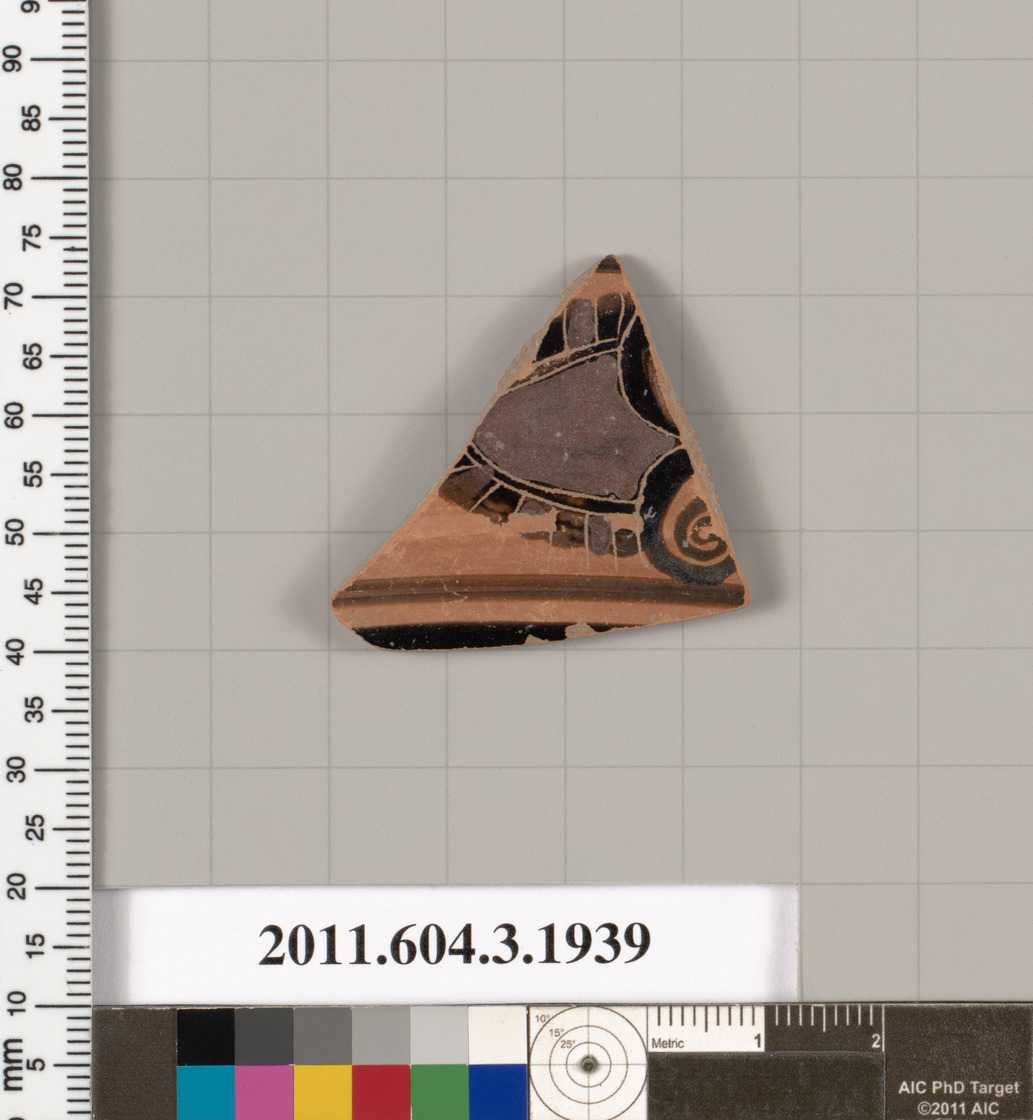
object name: kylix fragment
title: Terracotta fragment of a kylix: Komast cup (drinking cup)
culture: greek, attic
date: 580-570 BCE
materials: terracotta